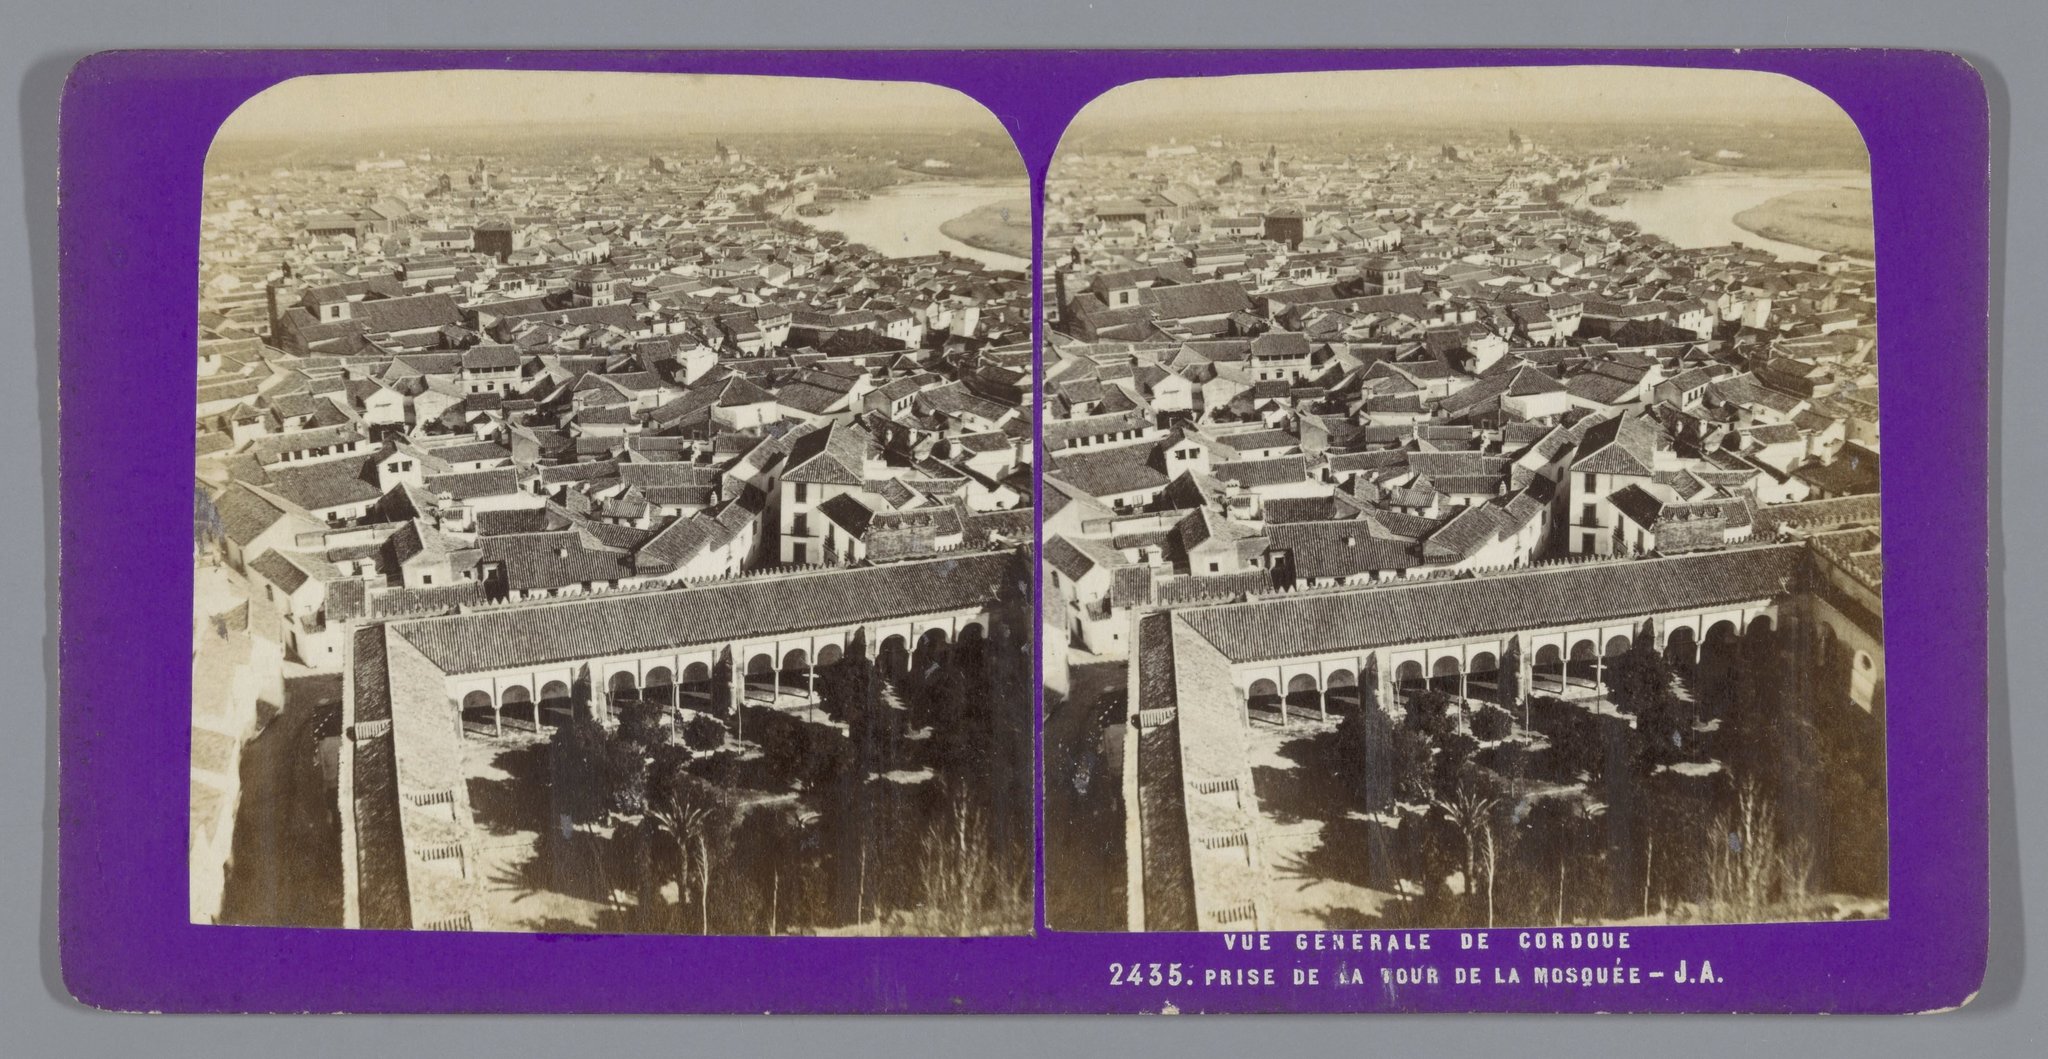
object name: stereograph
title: Vue generale de Cordoue prise de la Tour de la Mosquée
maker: jean andrieu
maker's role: fotograaf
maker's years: 1816-1872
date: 1862-1876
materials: cardboard, photographic support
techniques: albumen print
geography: córdoba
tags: prospect of city, town panorama, silhouette of city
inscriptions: number: ‘2435.’